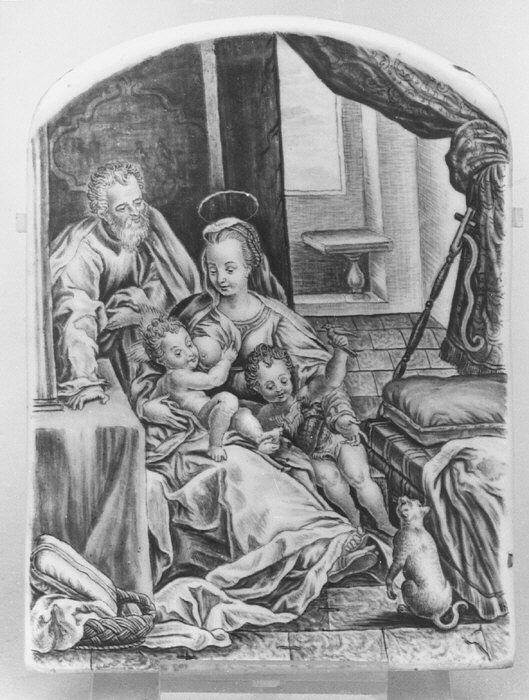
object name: plaque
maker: meissen manufactory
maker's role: manufactory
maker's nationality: german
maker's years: 1710-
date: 1750-1760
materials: hard paste porcelain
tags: infants,men,women,cats